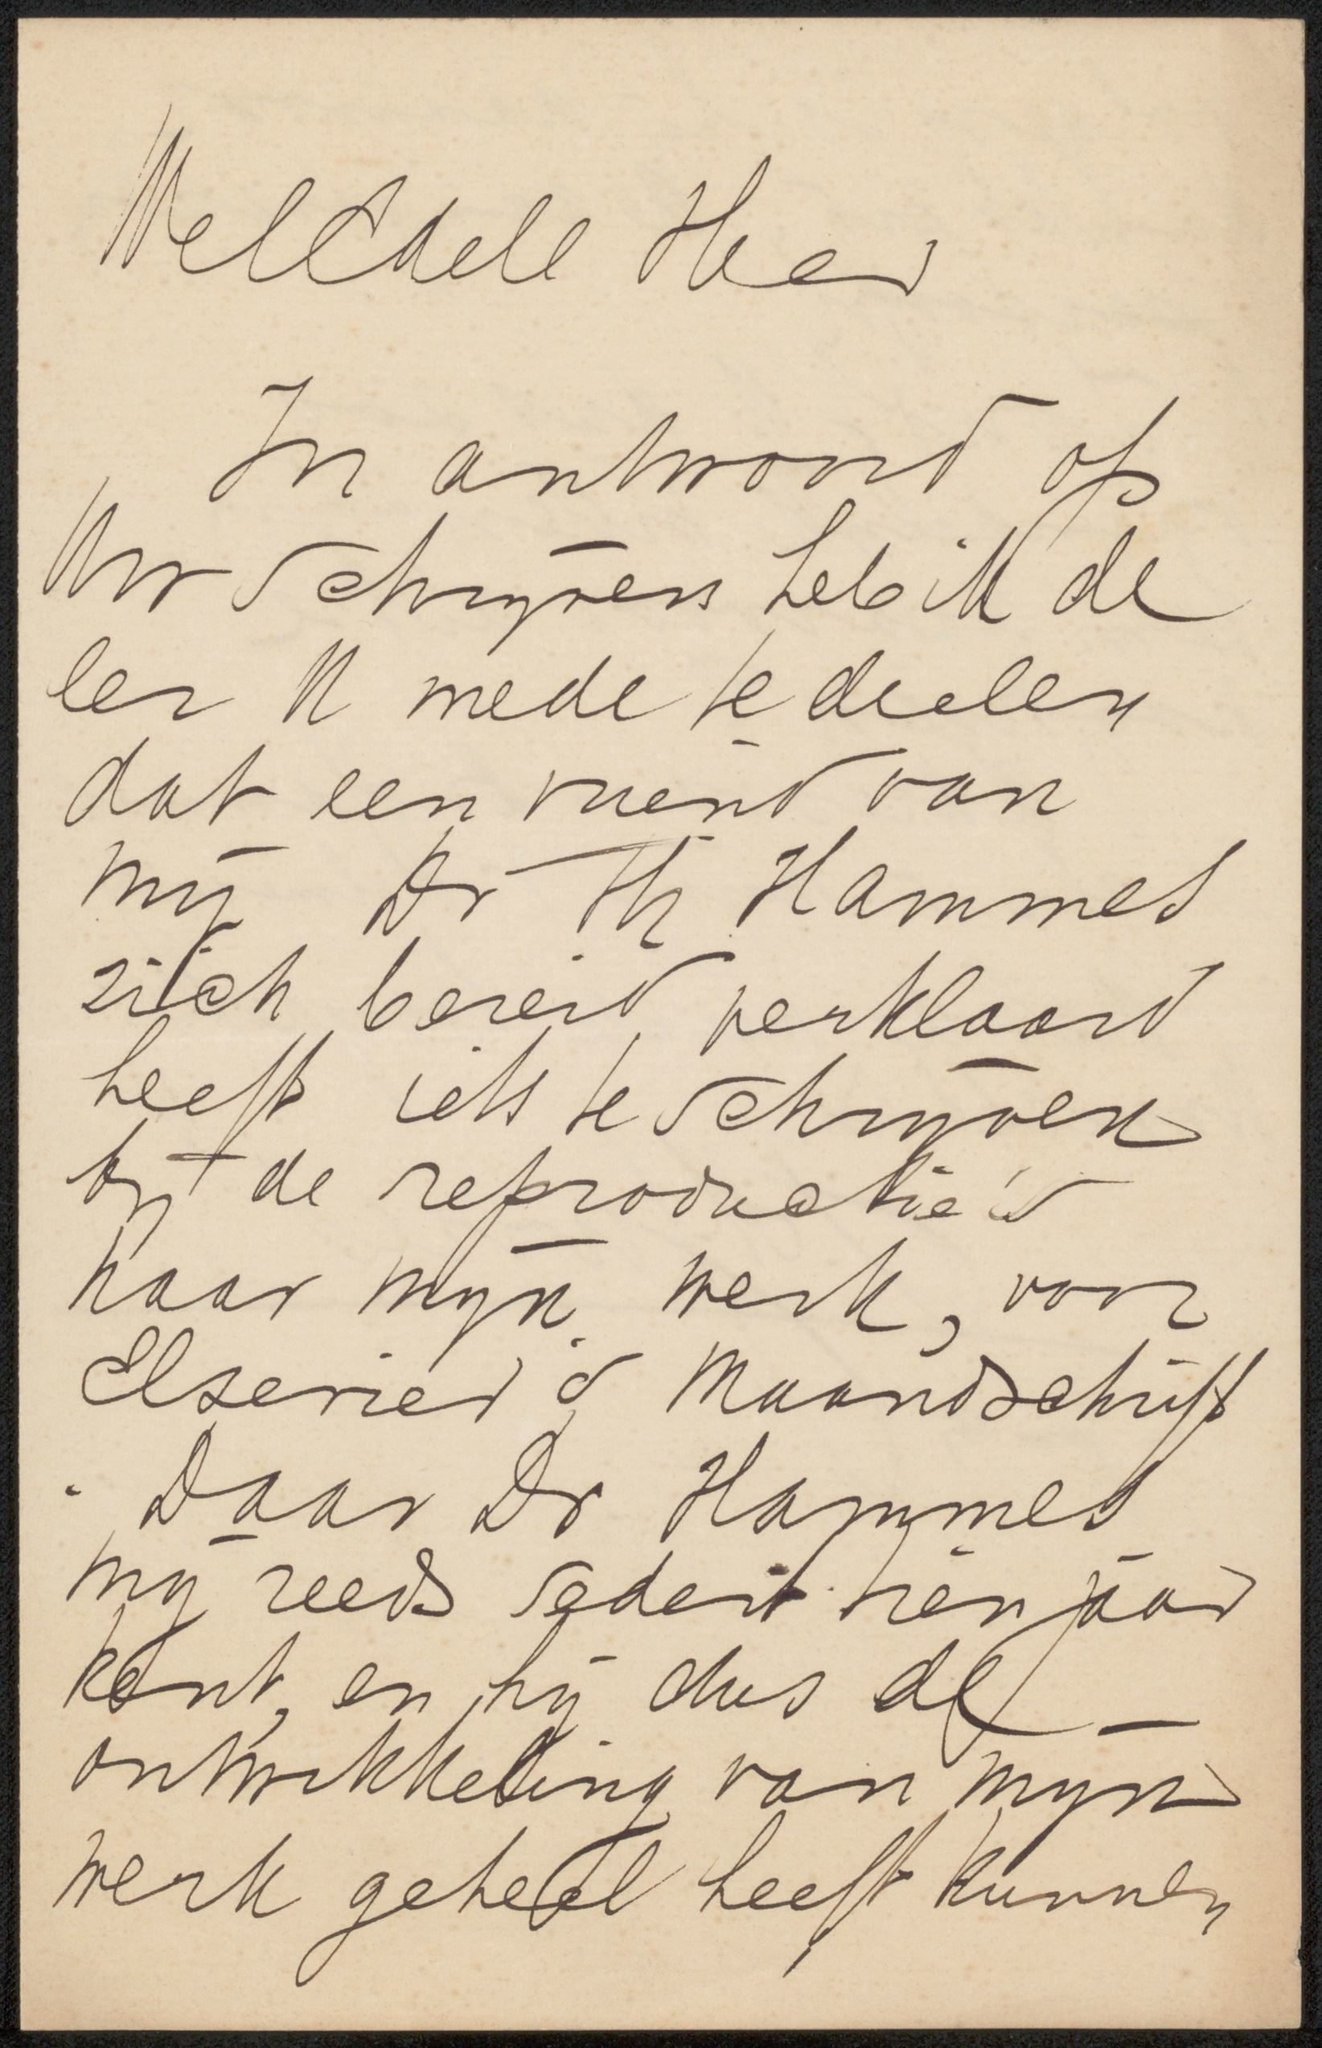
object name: letter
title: Brief aan Philip Zilcken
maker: johannes hendricus jurres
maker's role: draughtsman, print maker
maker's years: 1875-1946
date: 1904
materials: ink, paper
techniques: pen, writing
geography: amsterdam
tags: the hague, painter, philip zilcken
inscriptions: collector's mark: ‘RPK’